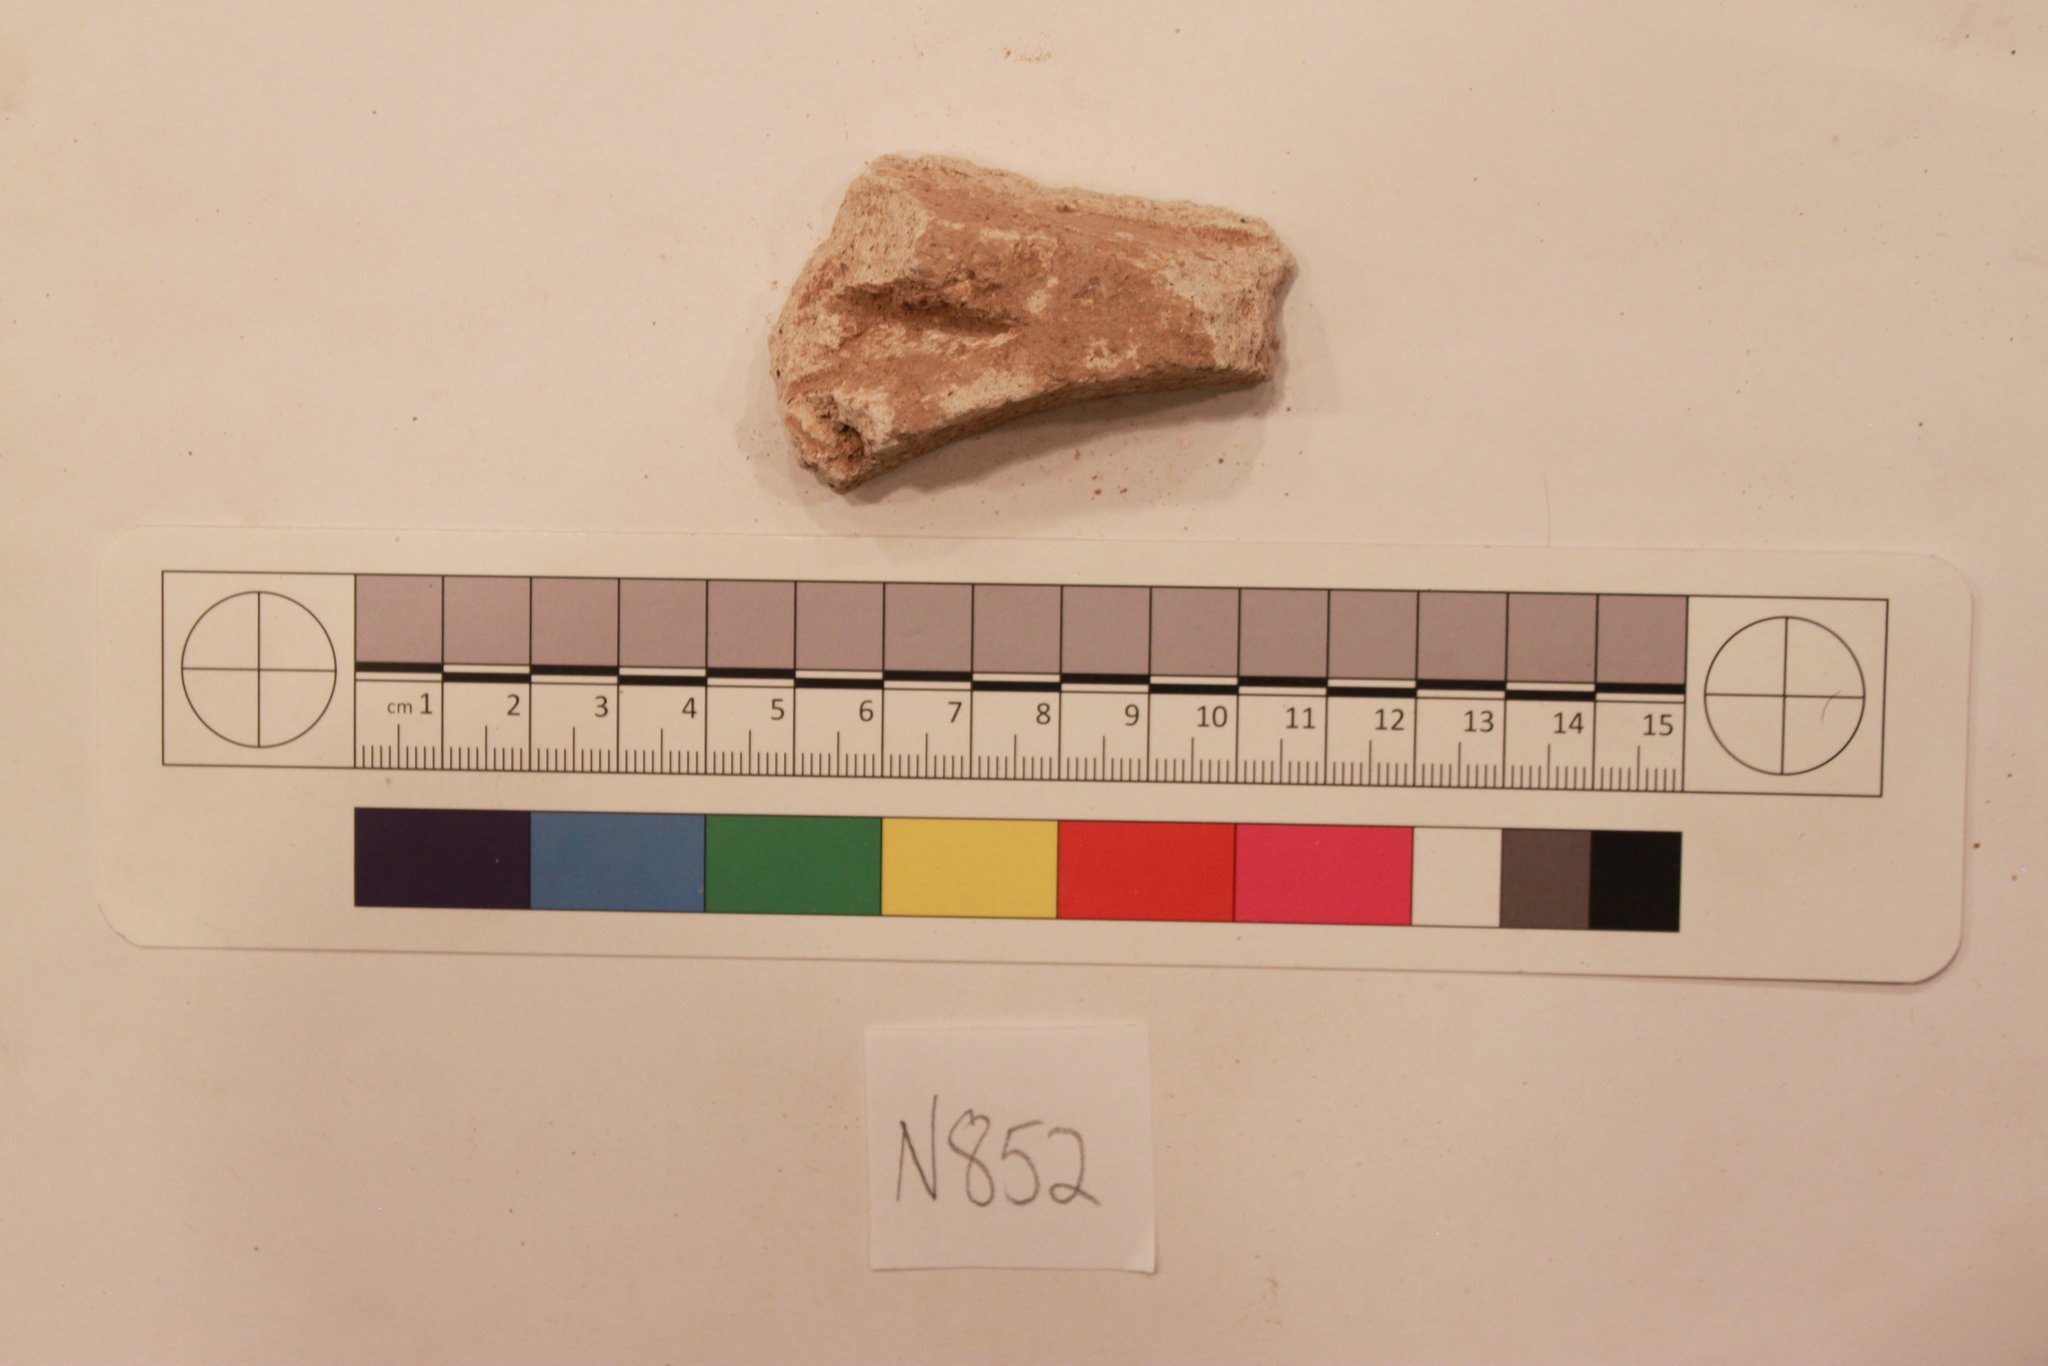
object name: fragment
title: Stucco Fragment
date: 701-1200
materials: plaster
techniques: carving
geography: iran